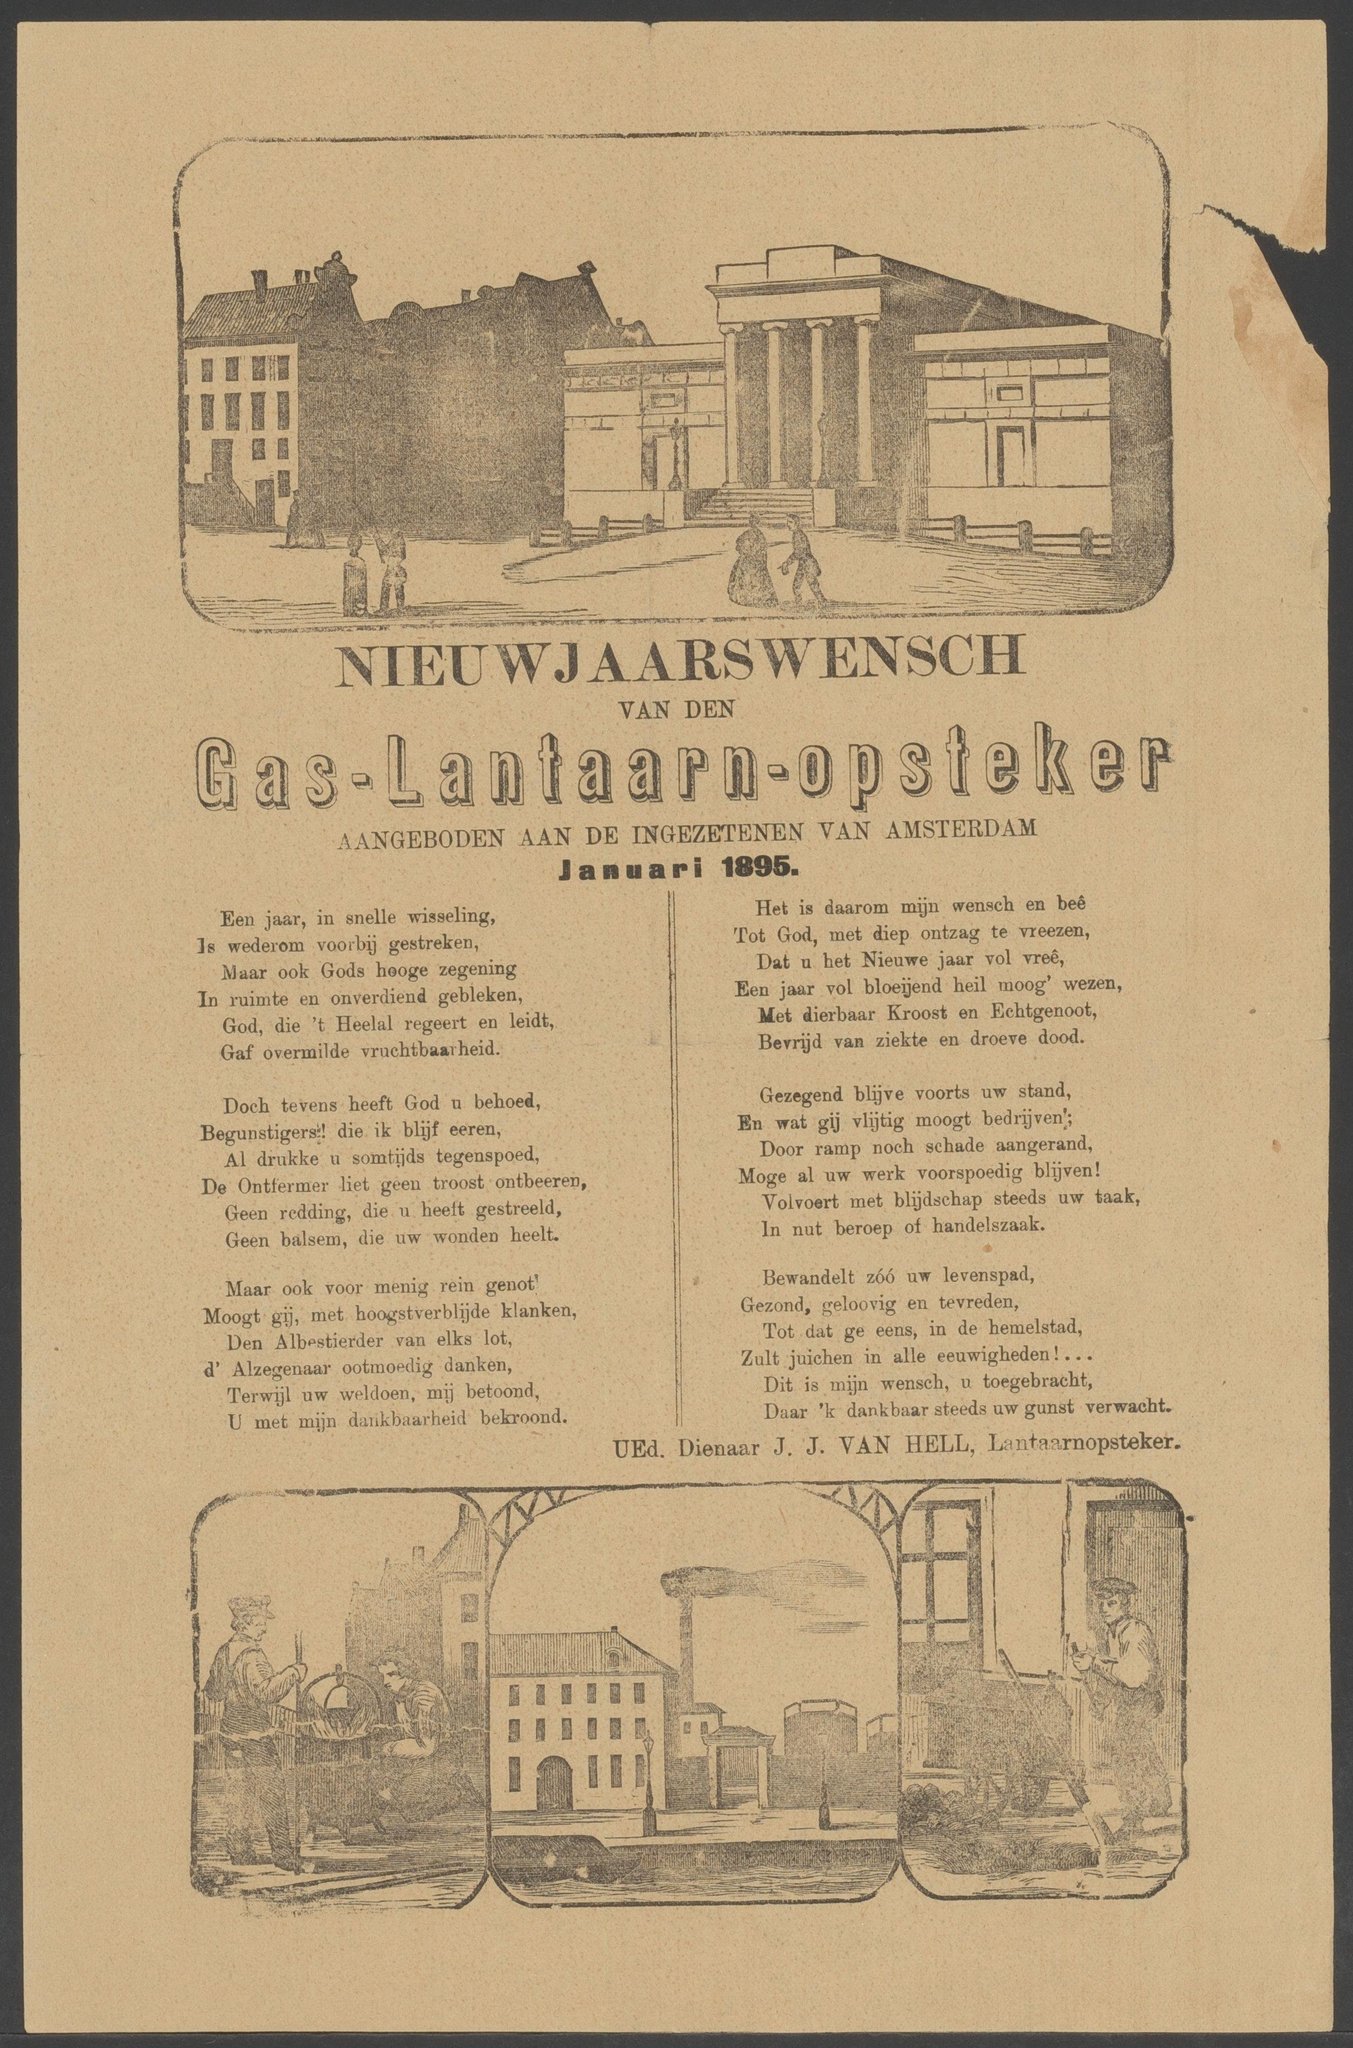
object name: print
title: Nieuwjaarschwensch van den Gas-lantaarnopsteker, aangeboden aan de ingezetenen van Amsterdam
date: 1895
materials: paper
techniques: letterpress printing, engraving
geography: amsterdam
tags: gas-lamp, gas supply, digging (industrial process), street lighting, amsterdam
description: Nieuwjaarswens van de Amsterdamse gaslantaarnopstekers voor het jaar 1895. Centraal een vers in twee kolommen. Bovenaan de Dam met de beurs van Zocher te Amsterdam. Onderaan de Hollandsche Gasfabriek en twee gasfitters aan het werk. Van de gaslantaarnopsteker: J.J. van Hell. Onderwerpsrubrieken binnen de Atlas Zeden en Gewoonten: Zeden en gewoonten in engeren zin, Volksleven, Volksbladen, Nieuwjaars- en Kerstwenschen, Amsterdam.